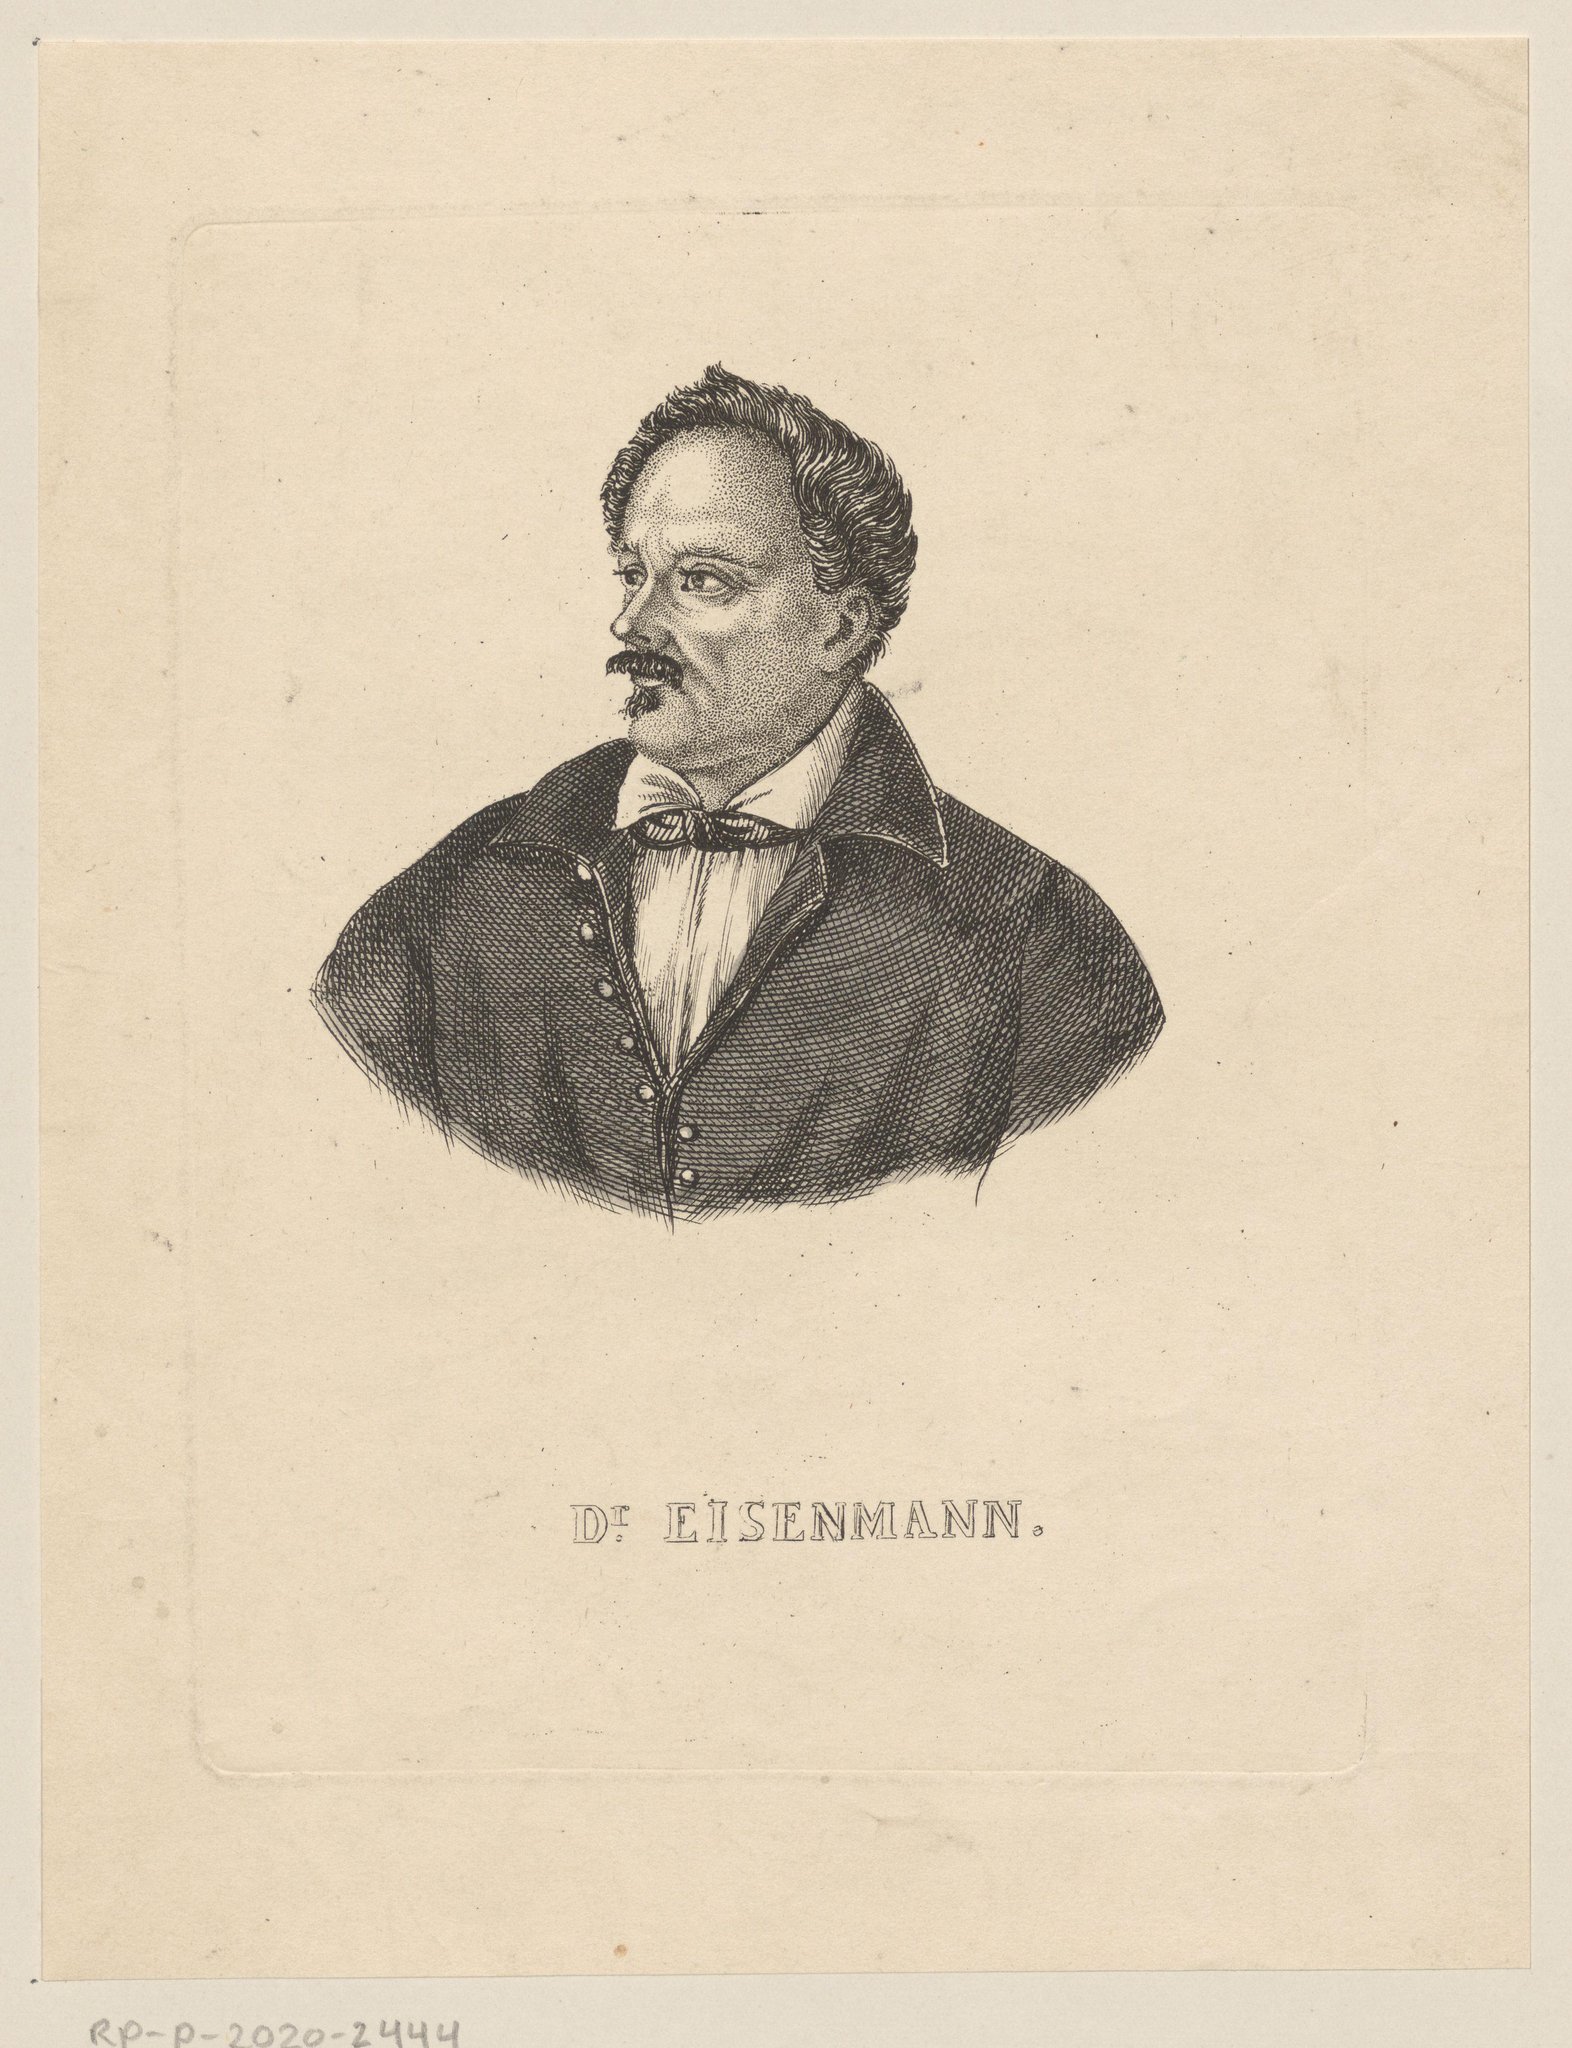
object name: print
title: Portret van Gottfried Eisenmann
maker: Anonymous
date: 1830-1880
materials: paper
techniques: etching, intaglio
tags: politician, historical persons, physician, doctor (+ portrait of scholar, scientist)